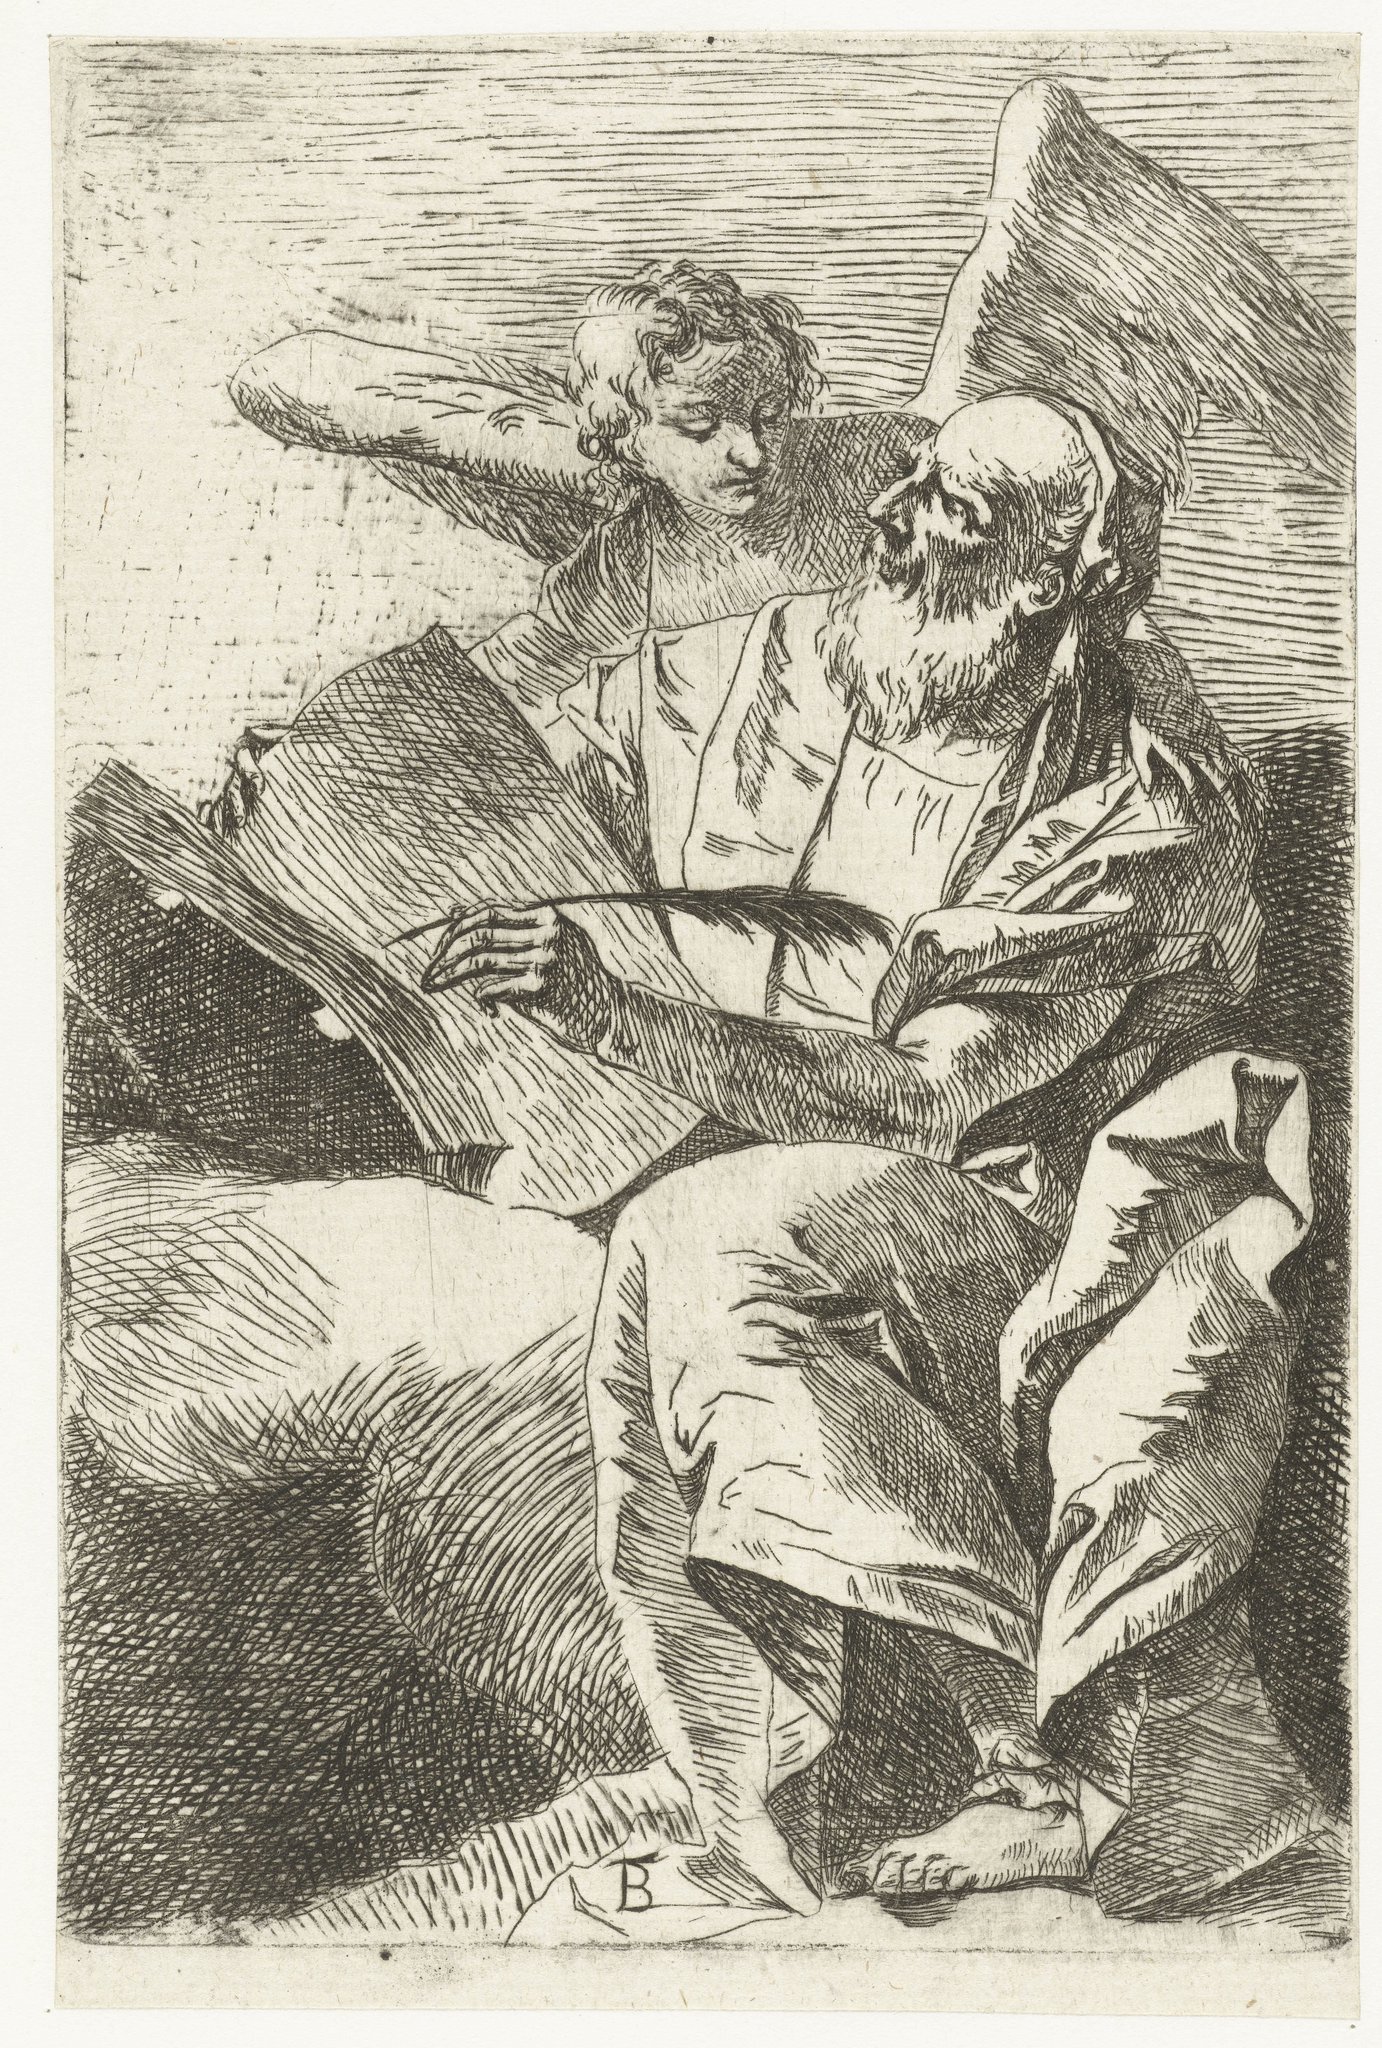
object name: print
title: Evangelist Matteus met engel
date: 1700-1799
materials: paper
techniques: etching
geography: italy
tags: the apostle and evangelist matthew (mattheus); possible attributes: angel, axe, book, halberd, pen and inkhorn, purse, scroll, square, sword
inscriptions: collector's mark: Lugt 2228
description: Prent uit serie van vier prenten met evangelisten. De toeschrijving van de prenten is onduidelijk.